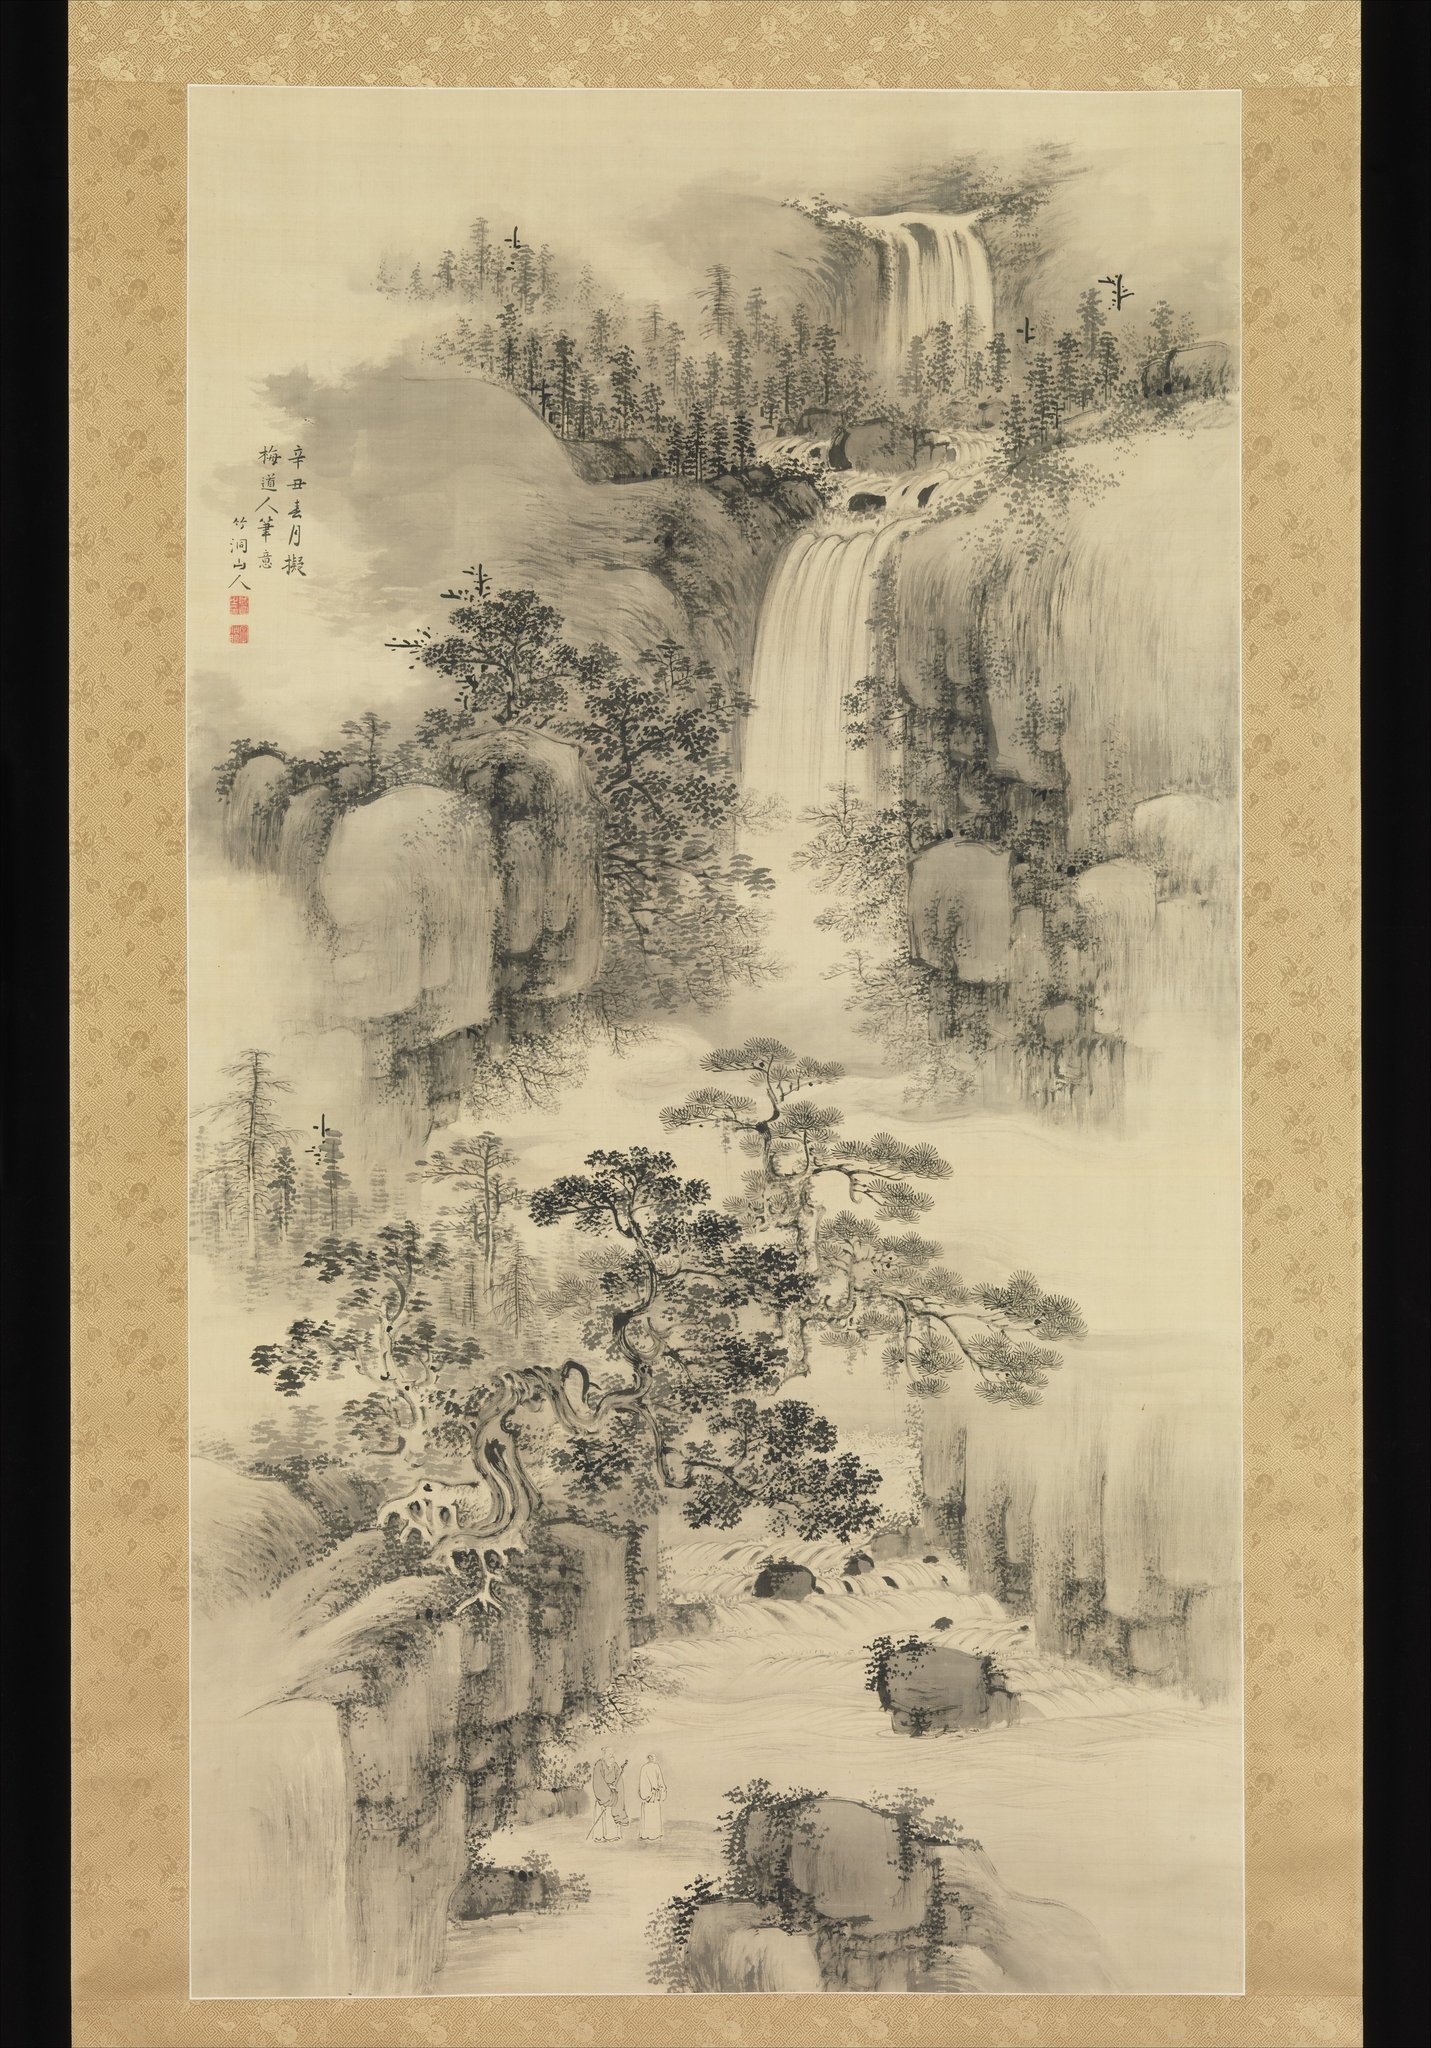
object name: hanging scroll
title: Landscape with Waterfall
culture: japanese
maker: nakabayashi chikutō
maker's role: artist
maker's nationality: japanese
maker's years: 1776-1853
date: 1841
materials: ink, paper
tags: waterfalls,landscapes